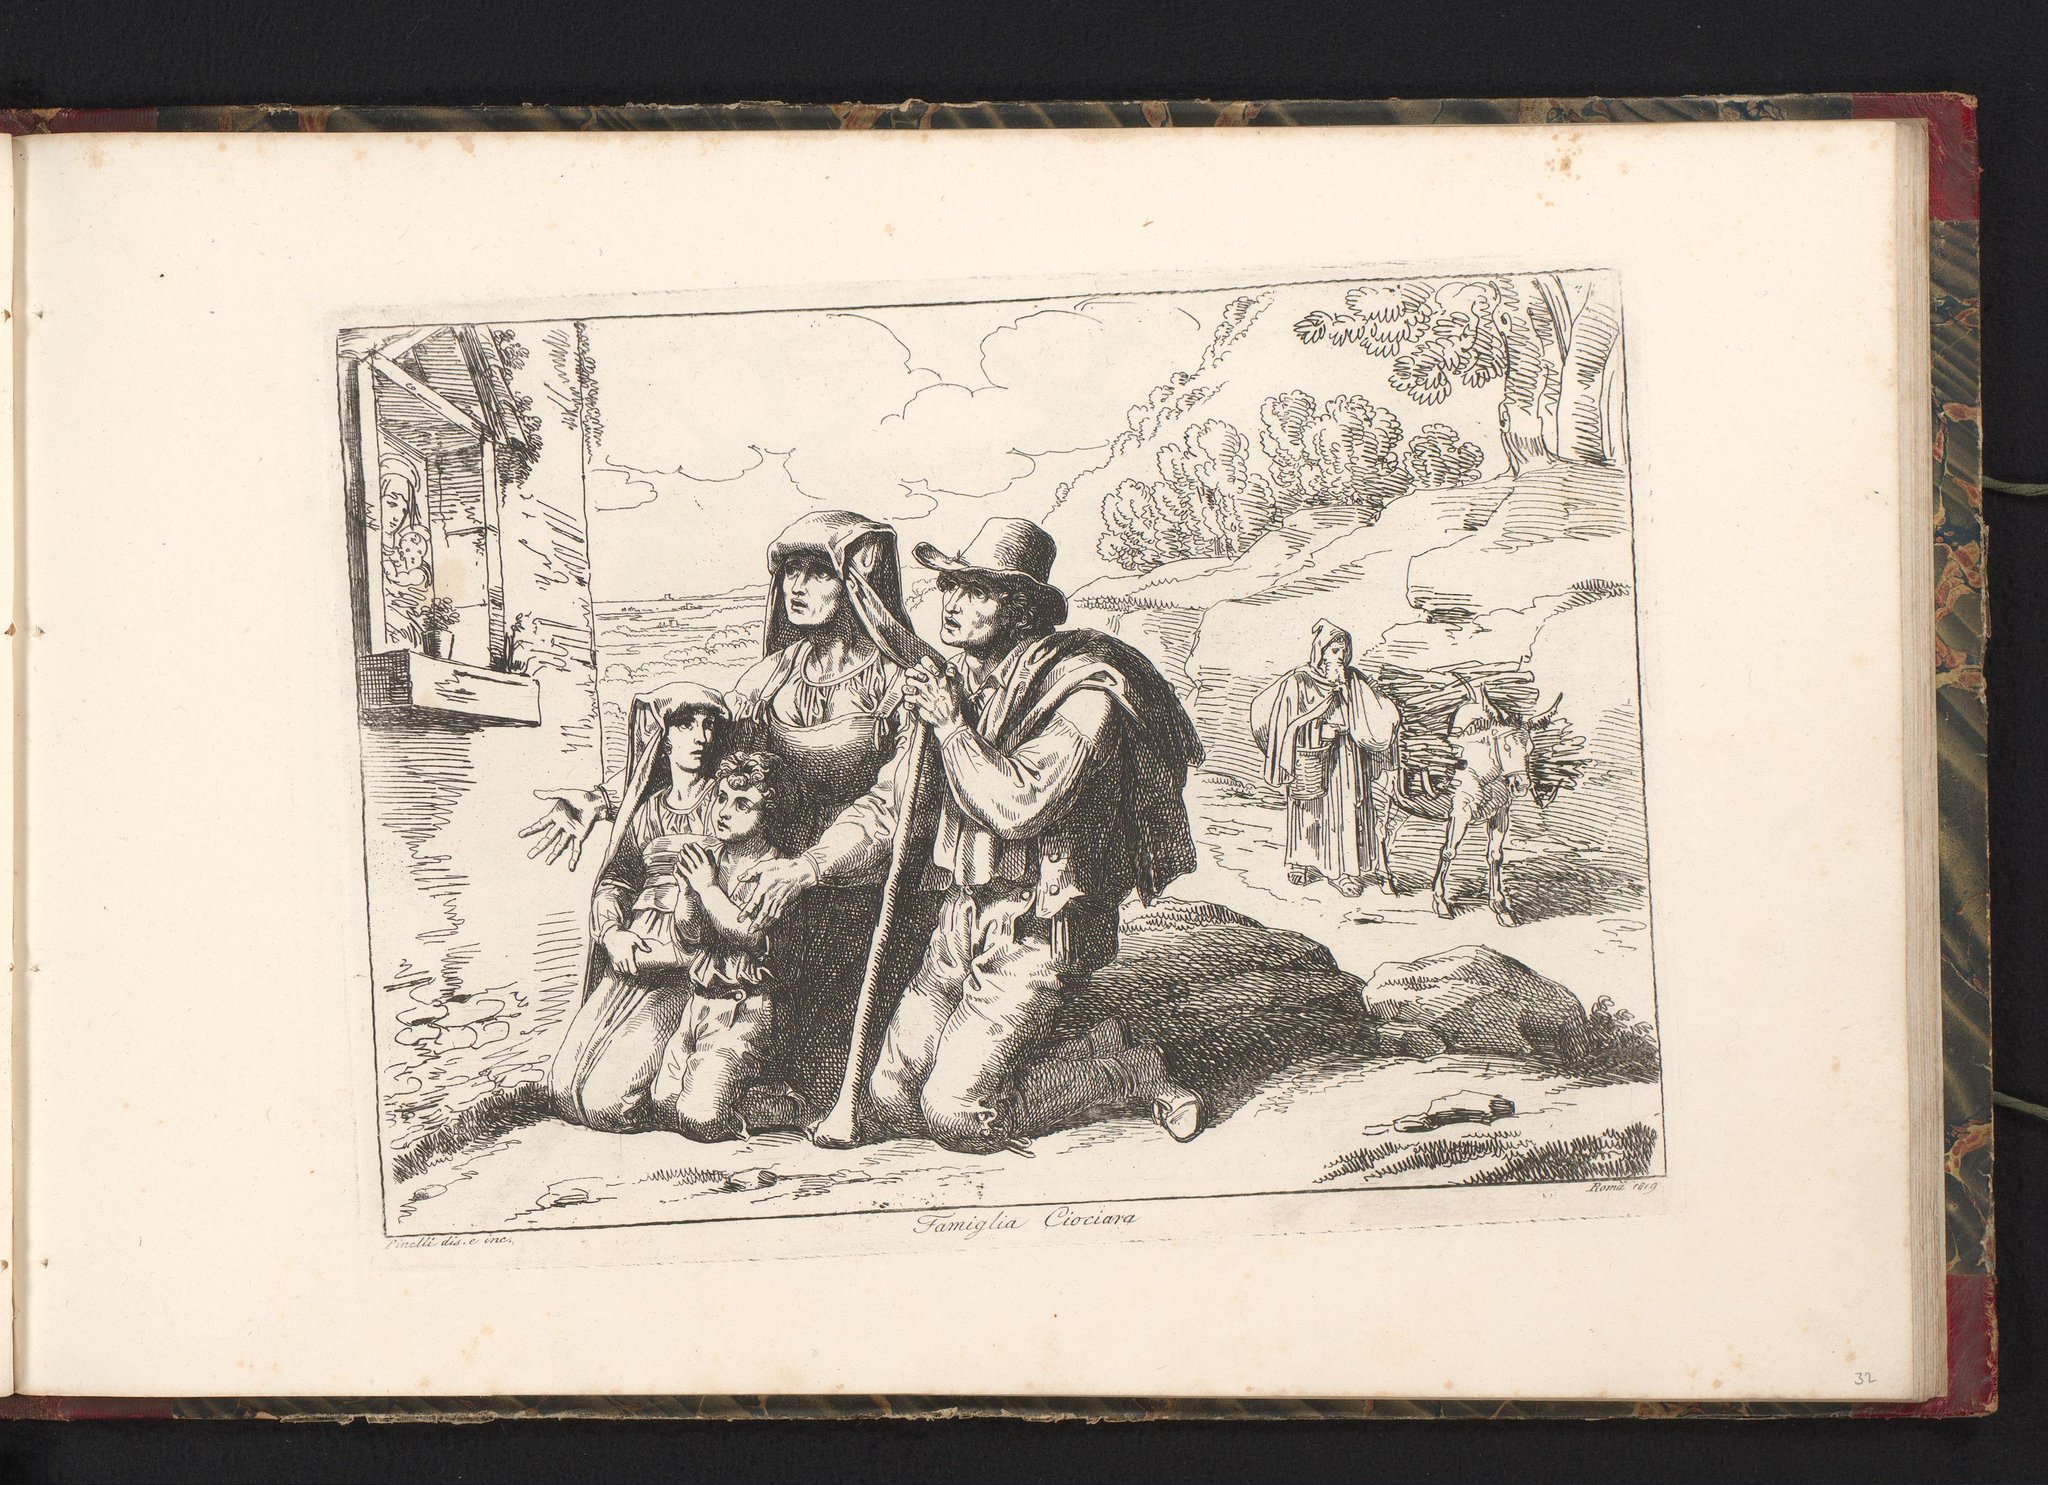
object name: album leaf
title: Kostuumprenten met figuren uit Rome en omgeving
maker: bartolomeo pinelli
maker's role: draughtsman, print maker, sculptor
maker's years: 1781-1835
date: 1819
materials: paper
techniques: etching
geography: rome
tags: city-view, and landscape with man-made constructions, madonna: i.e. mary with the christ-child, ass, donkey, folk costume, regional costume, 'en route', traveller under way, altar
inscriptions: date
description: Een familie uit het Ciociaria gebied, biddend langs een weg voor een klein altaar waarin Maria en het Christuskind zijn afgebeeld. Op de weg loopt een man met een bepakte ezel. De prent maakt deel uit van een album.